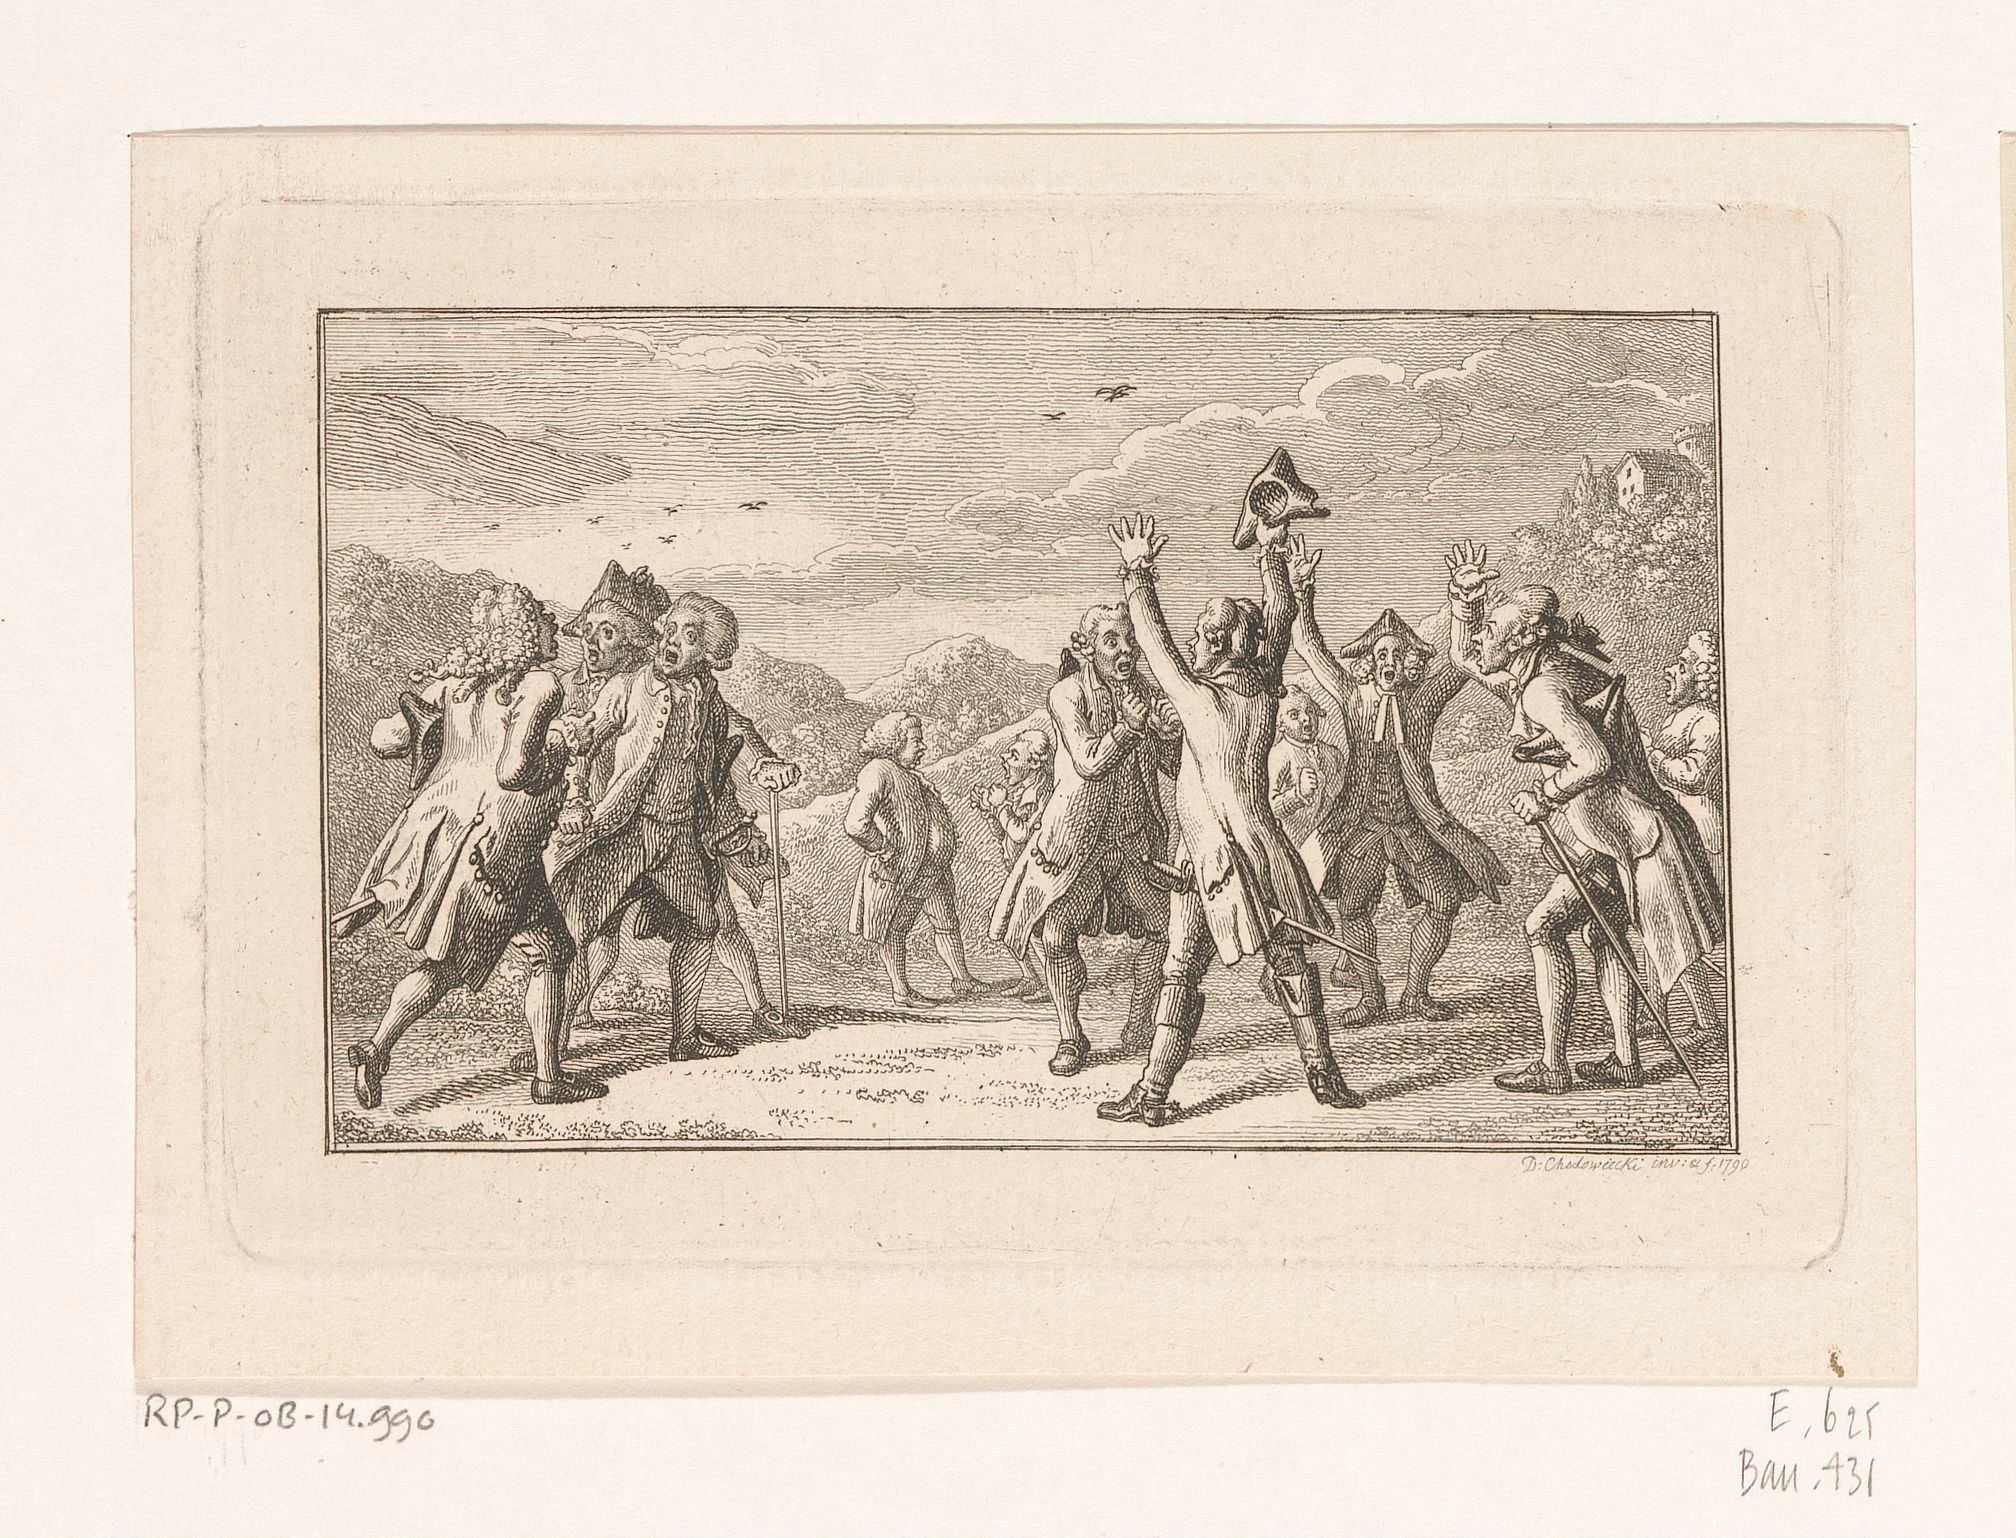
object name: print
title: Elf hevig gesticulerende mannen in een landschap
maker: daniel nikolaus chodowiecki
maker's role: draughtsman, print maker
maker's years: 1726-1801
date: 1790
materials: paper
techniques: etching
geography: berlin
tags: draughtsman, matthias claudius, gesture-language, literature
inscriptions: collector's mark: Lugt 2228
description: Een latere staat van deze prent is ook gebruikt in 'Asmus omnia sua secum portans, oder Sämtliche Werke des Wandsbecker Bothen', een verzamelwerk in de vorm van een tijdschrift, uitgegeven tussen 1775-1812.